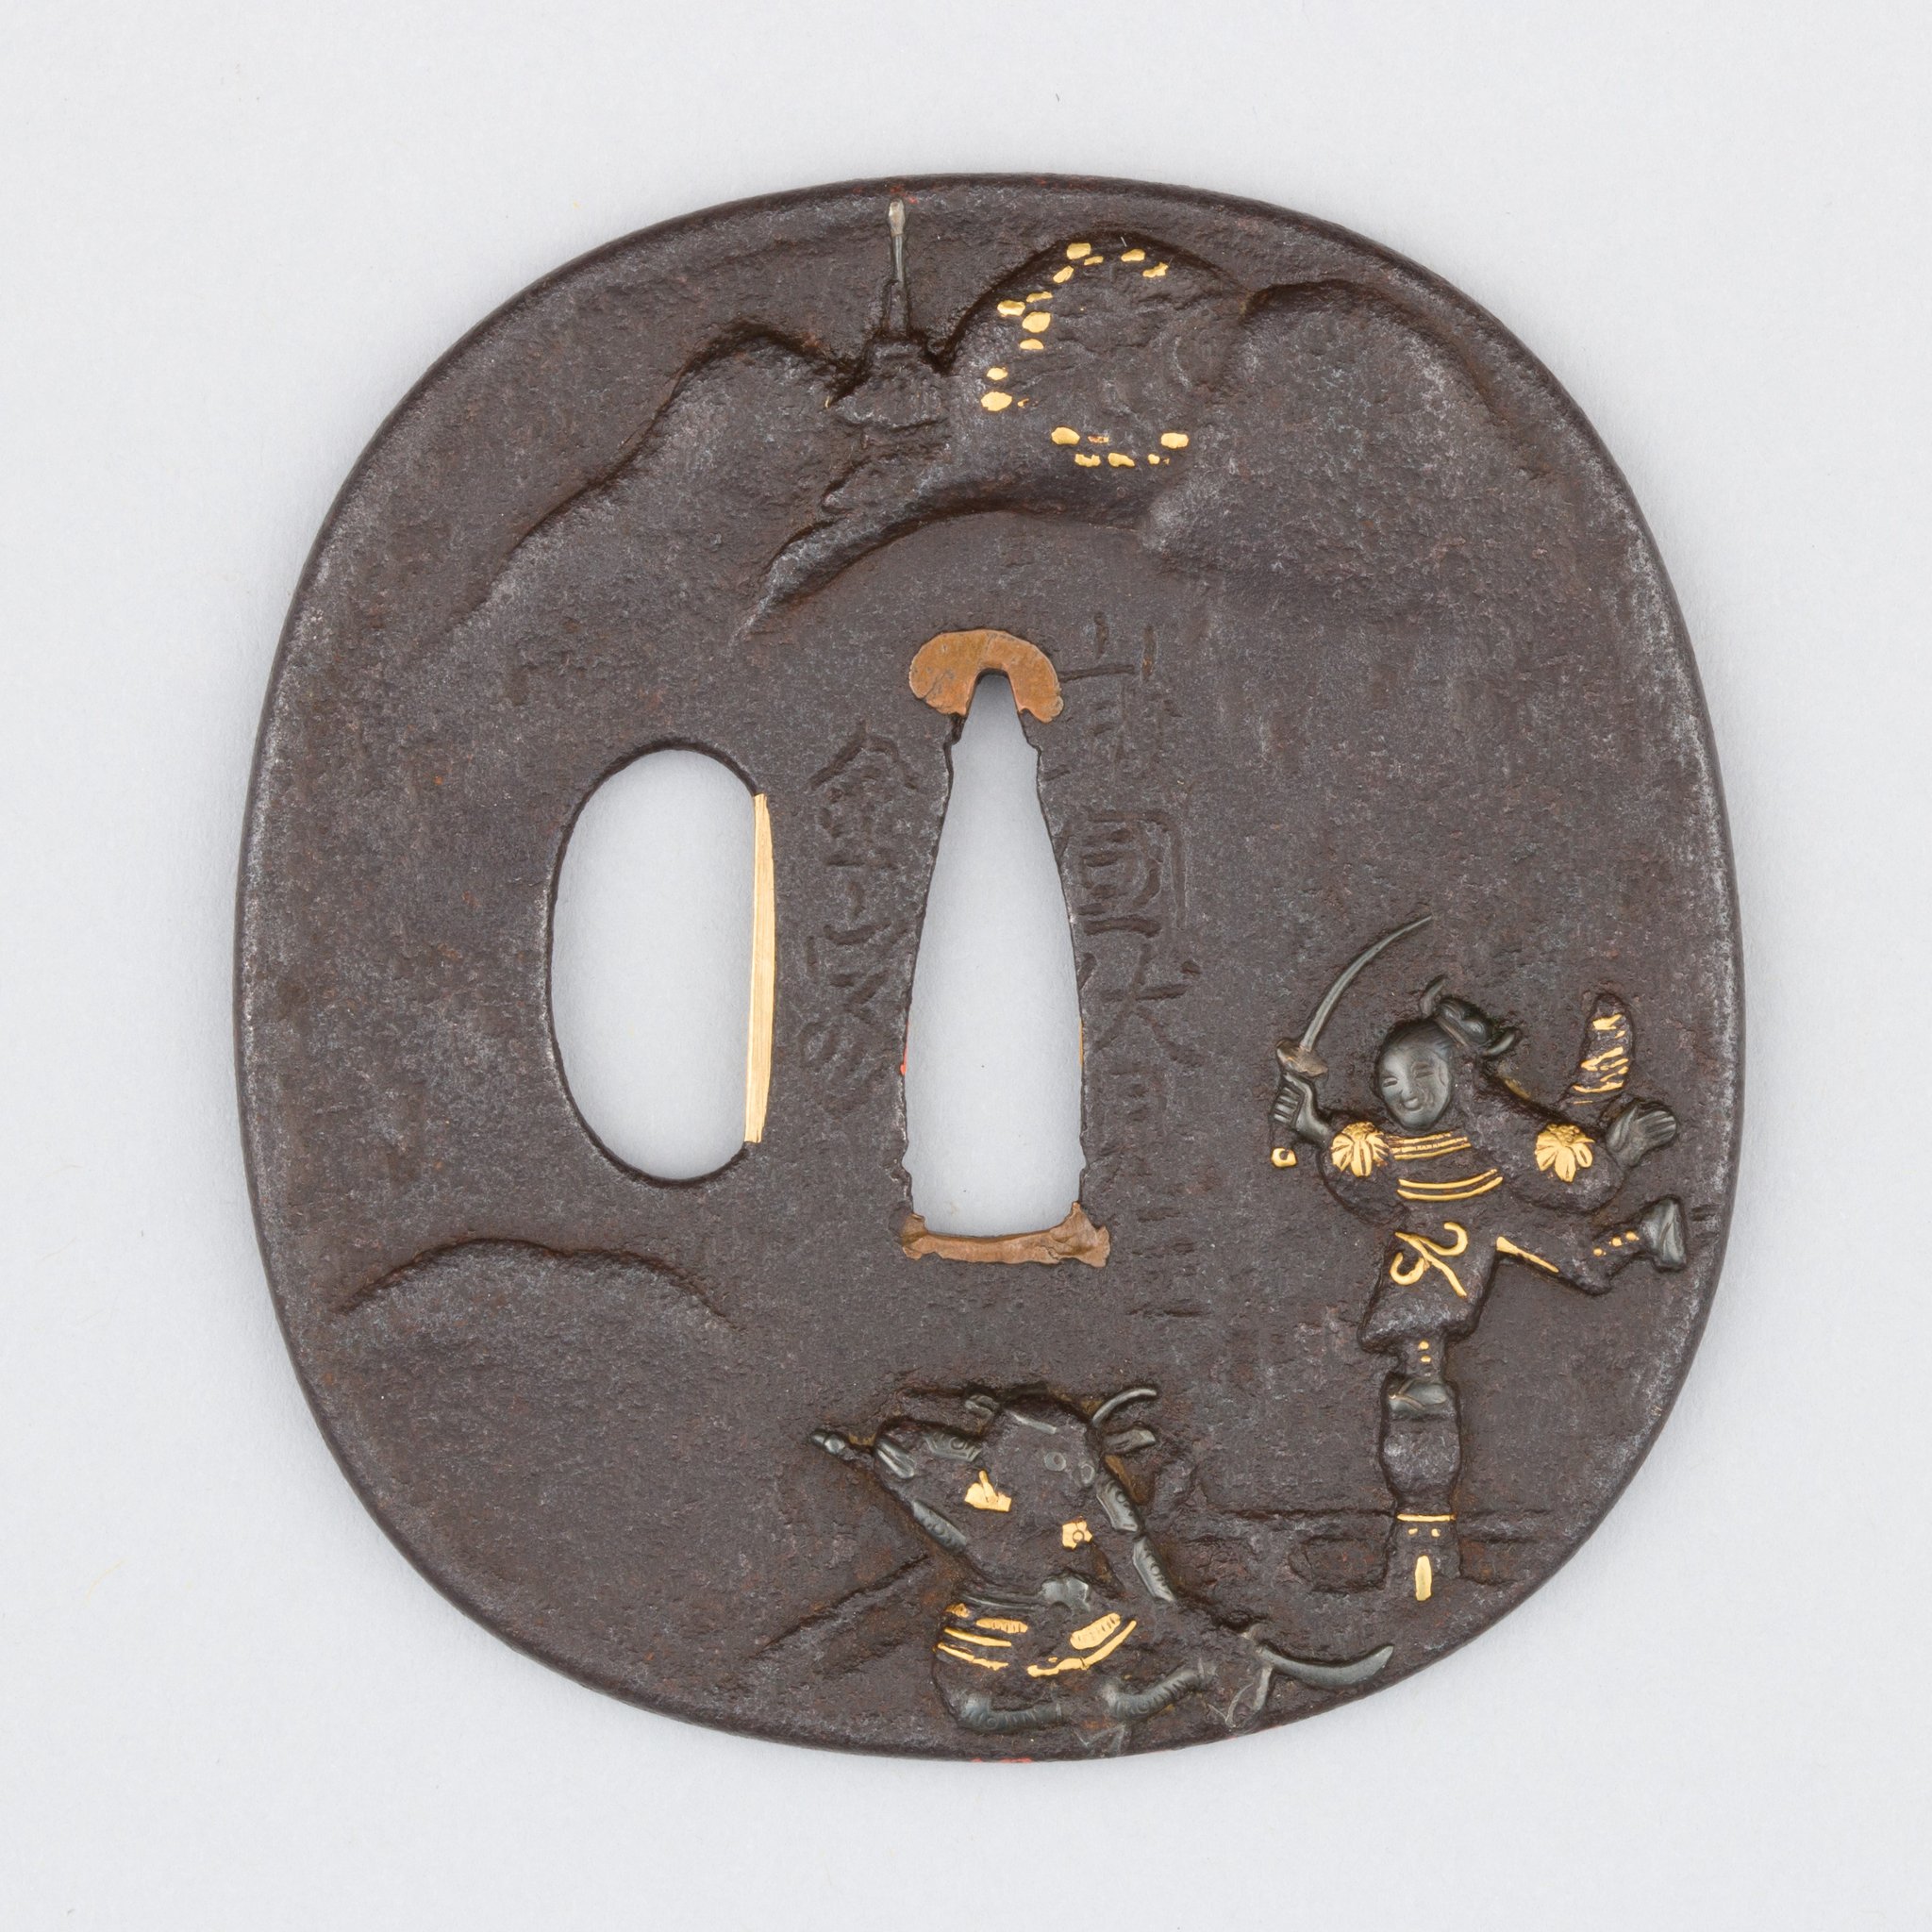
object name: sword guard tsuba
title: Sword Guard (Tsuba)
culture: japanese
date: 1567-1633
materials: copper, gold, iron, silver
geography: japan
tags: men